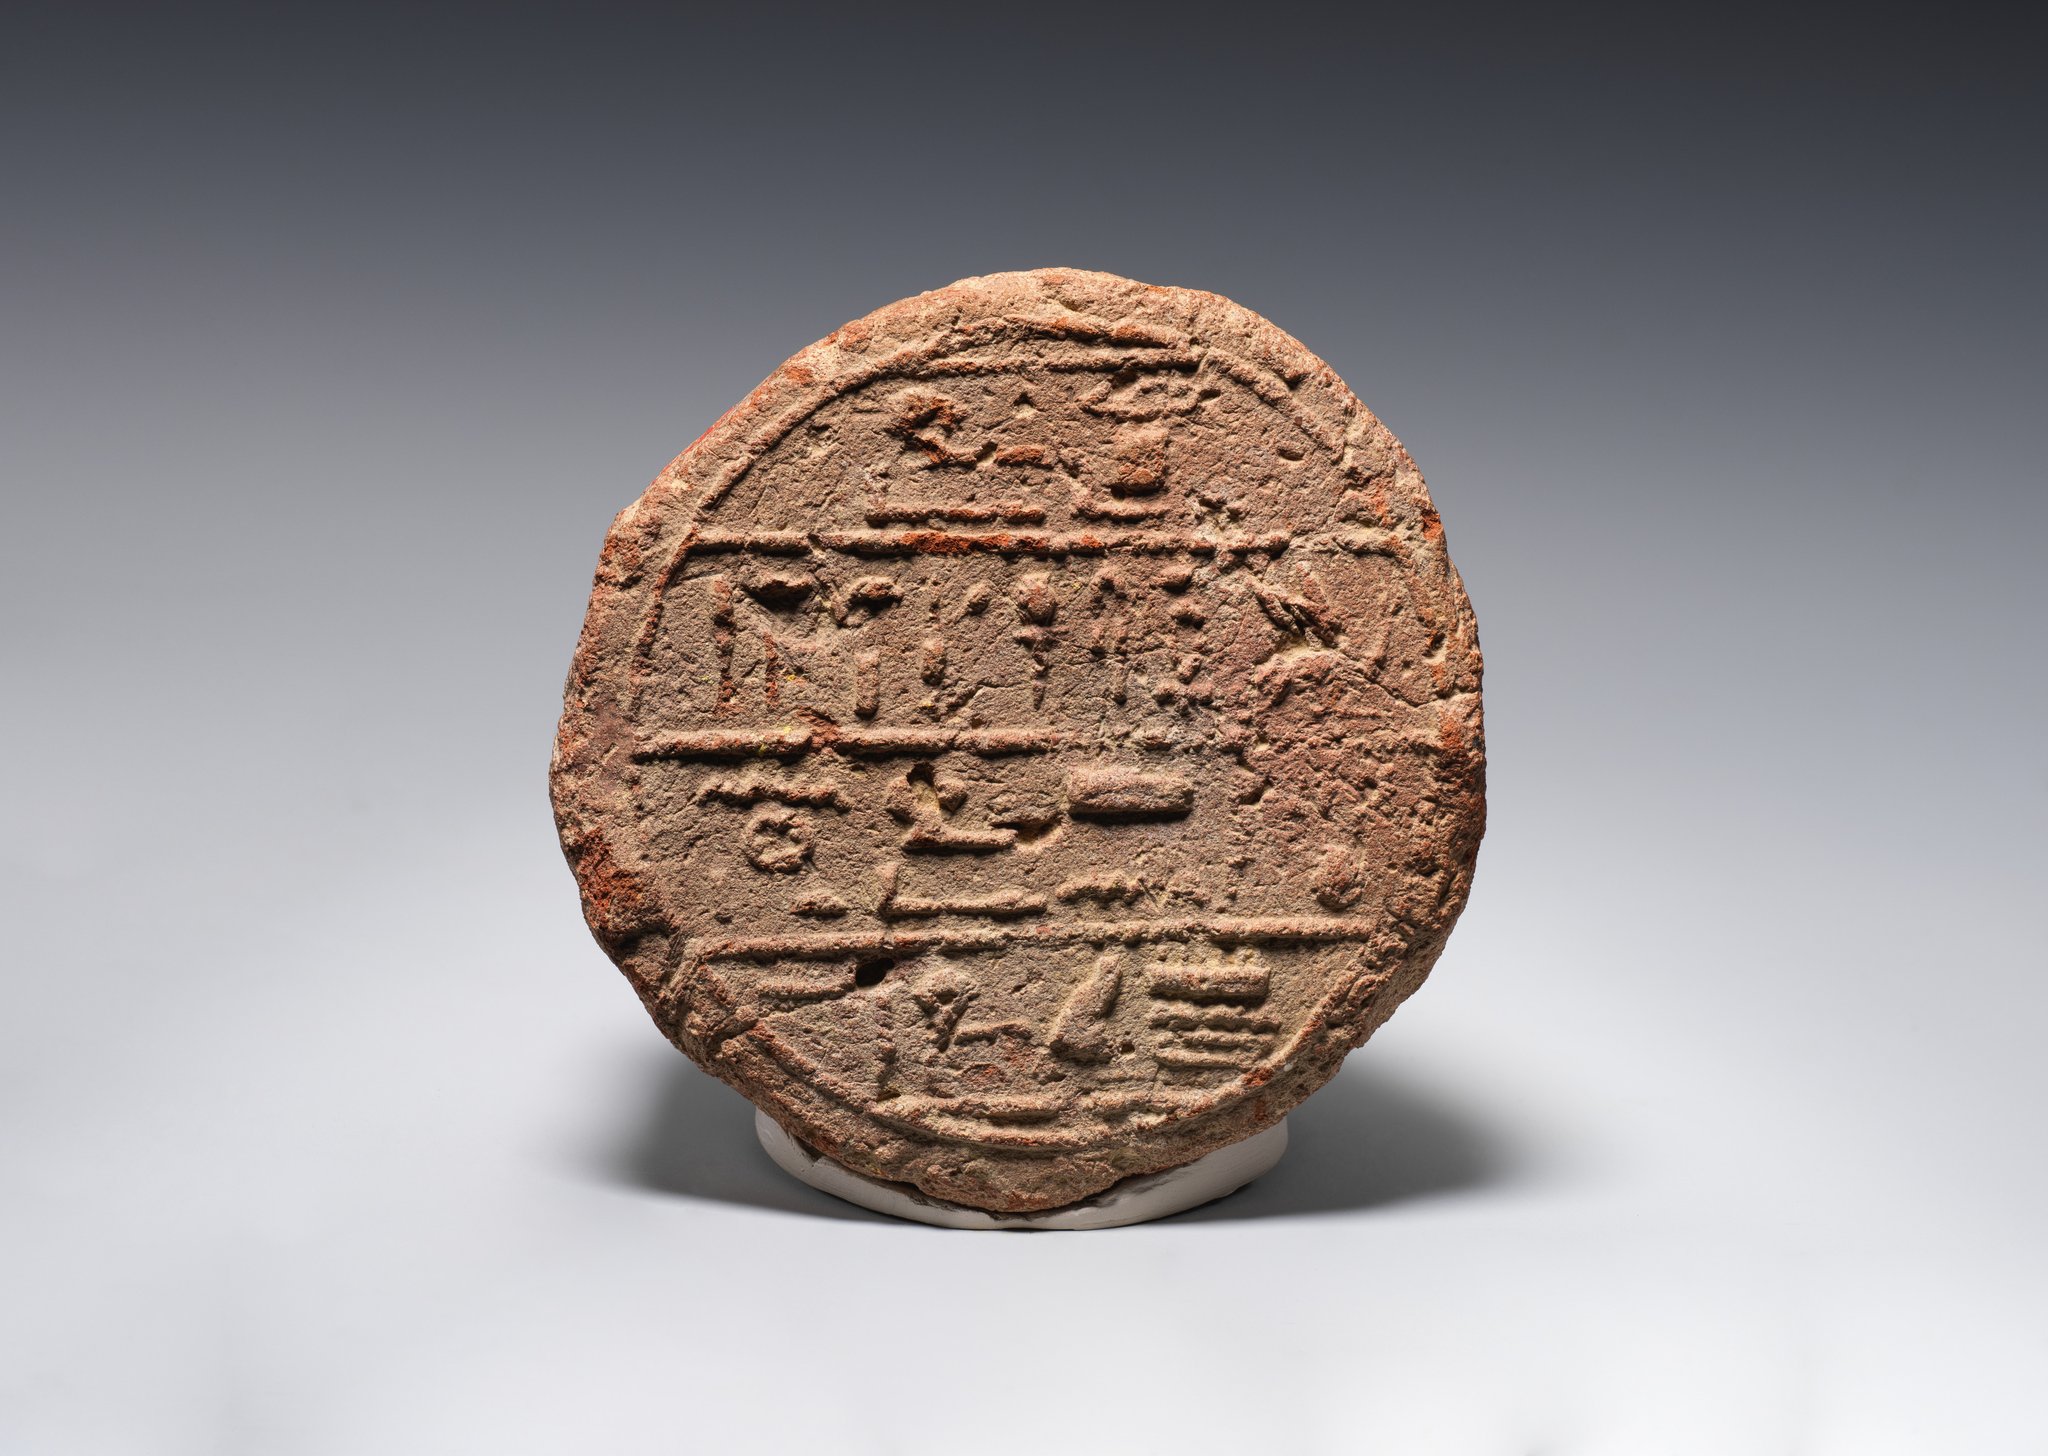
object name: cone, davy 449, montuemhat, tt 34, seal bearer, amun, mentuemhat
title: Funerary Cone of the Fourth Prophet of Amun Mentuemhat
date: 690-645 BCE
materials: pottery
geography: egypt